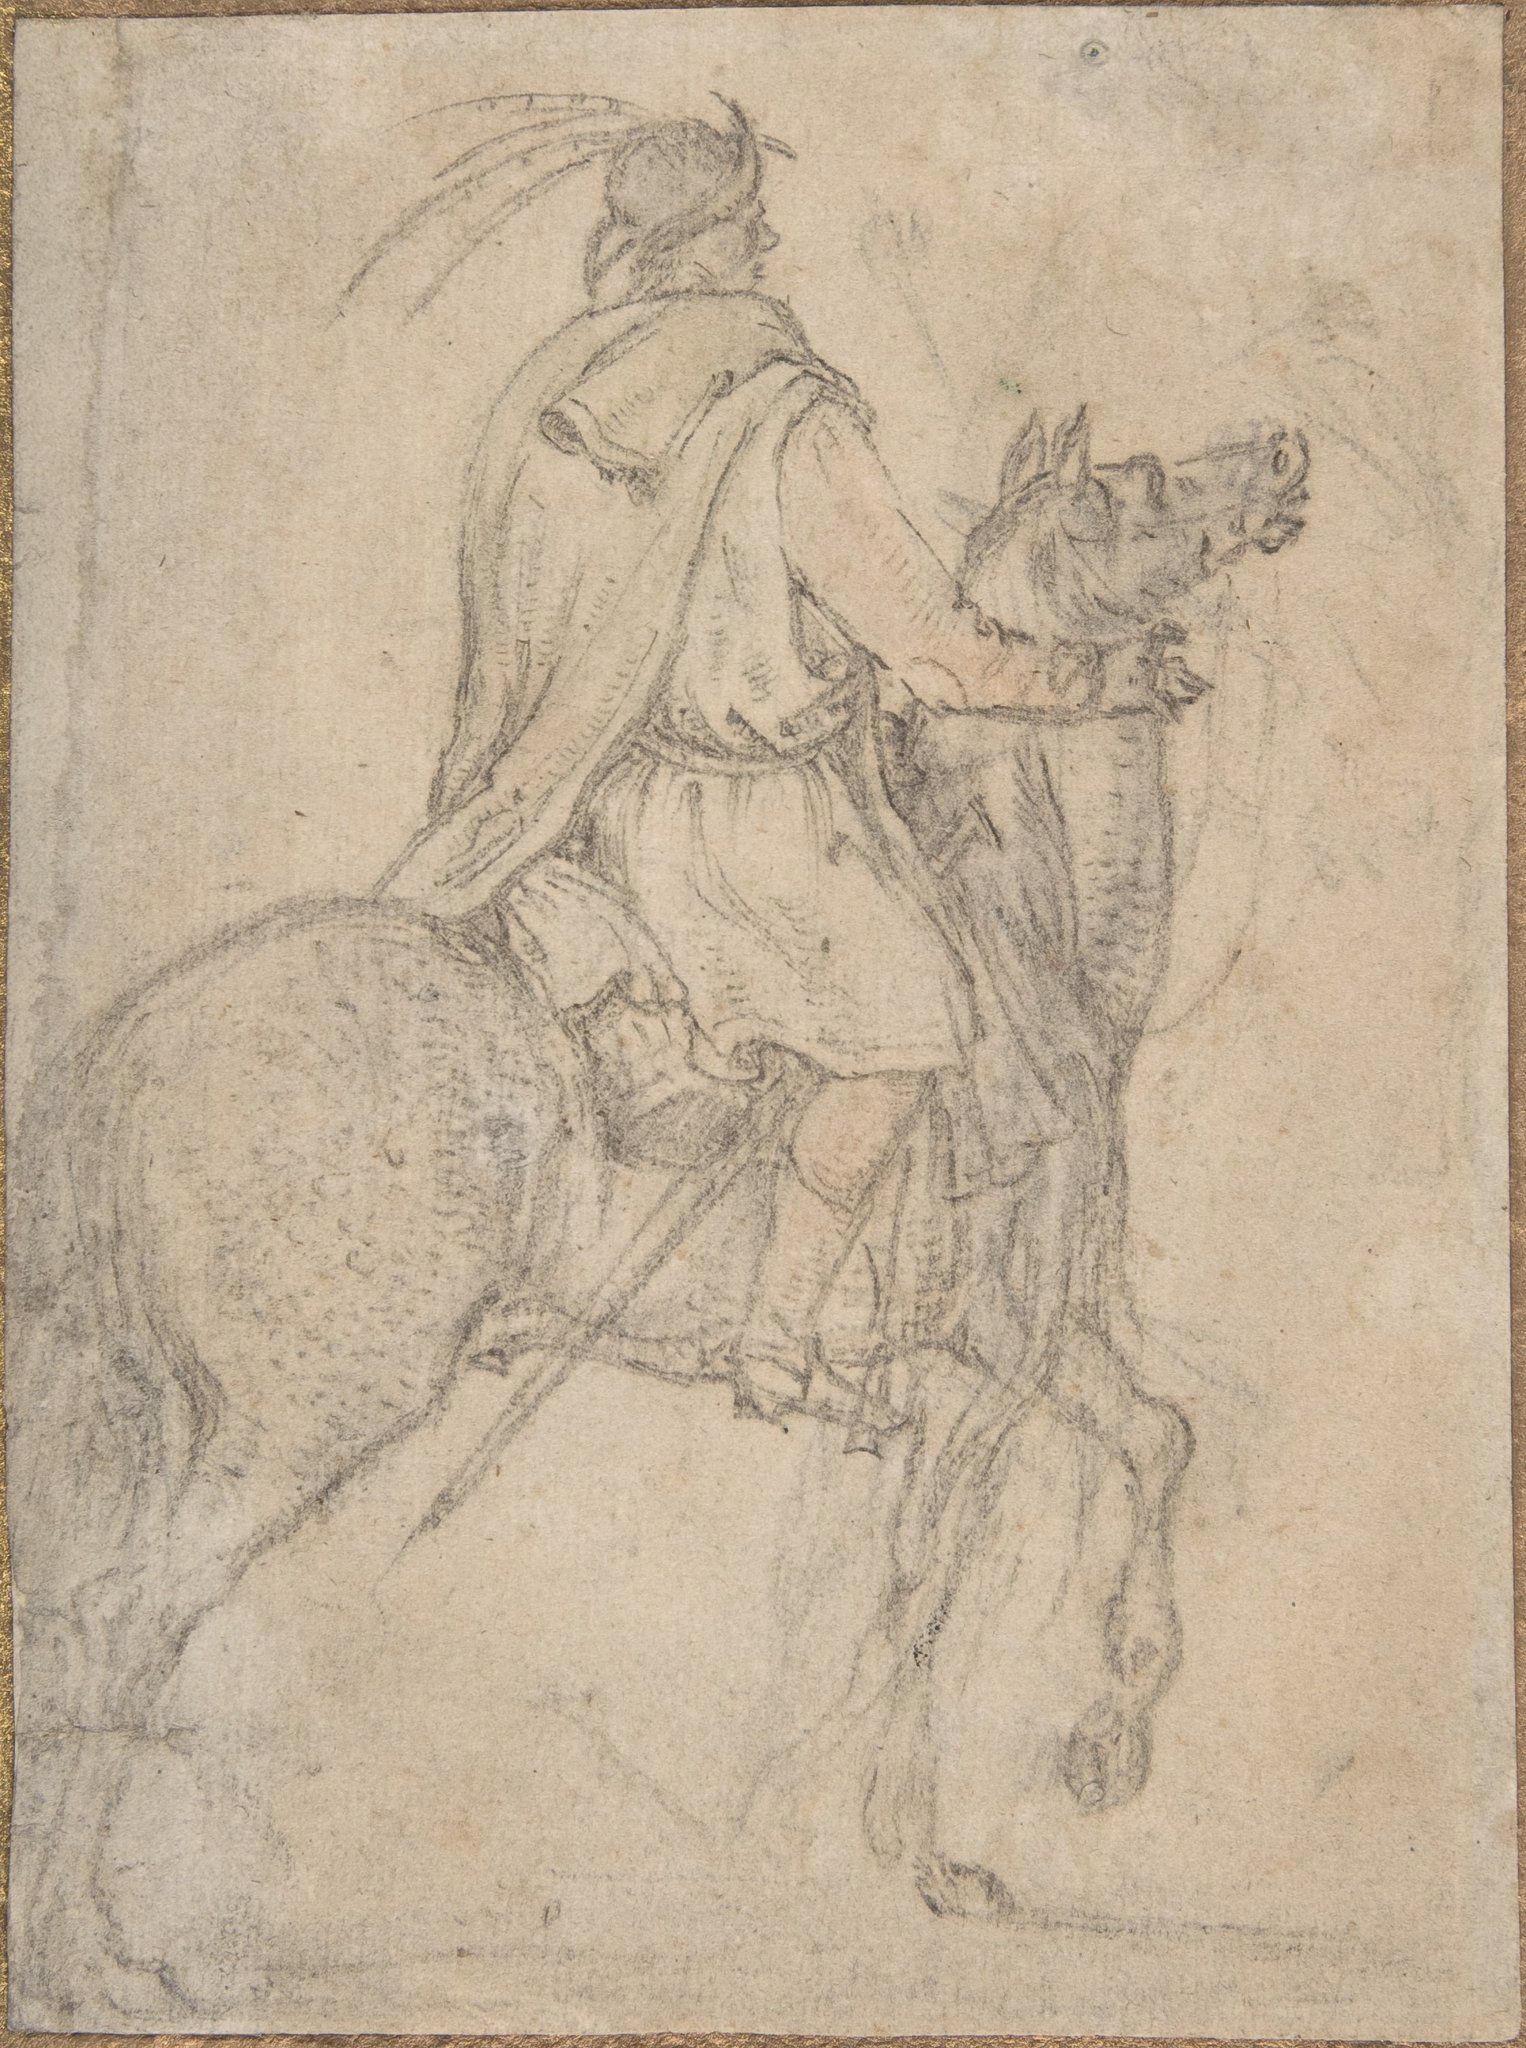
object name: drawing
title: A Hungarian Horseman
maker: roelandt savery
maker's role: artist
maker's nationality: flemish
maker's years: 1576-1639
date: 1567-1666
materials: chalk, watercolor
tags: men,horses